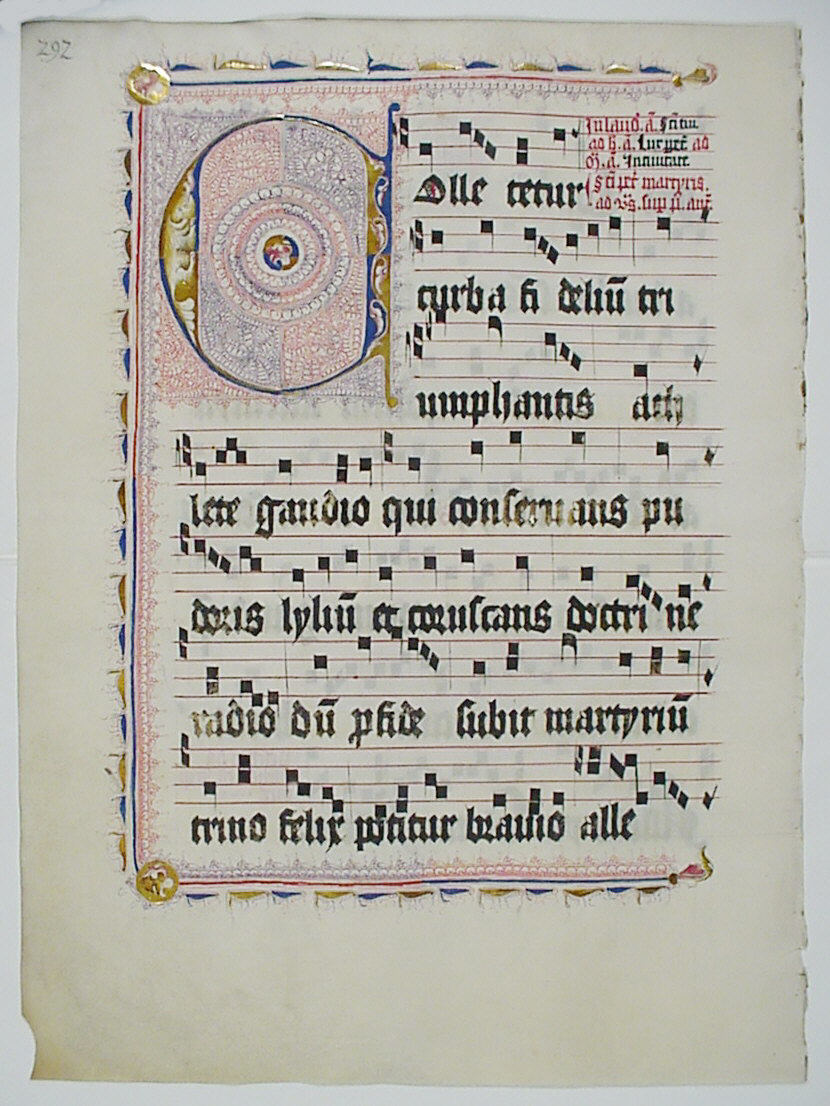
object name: antiphonary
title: Manuscript Leaf with Initial C, from an Antiphonary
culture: german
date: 1426-1450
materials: ink, metal leaf, parchment, paint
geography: germany